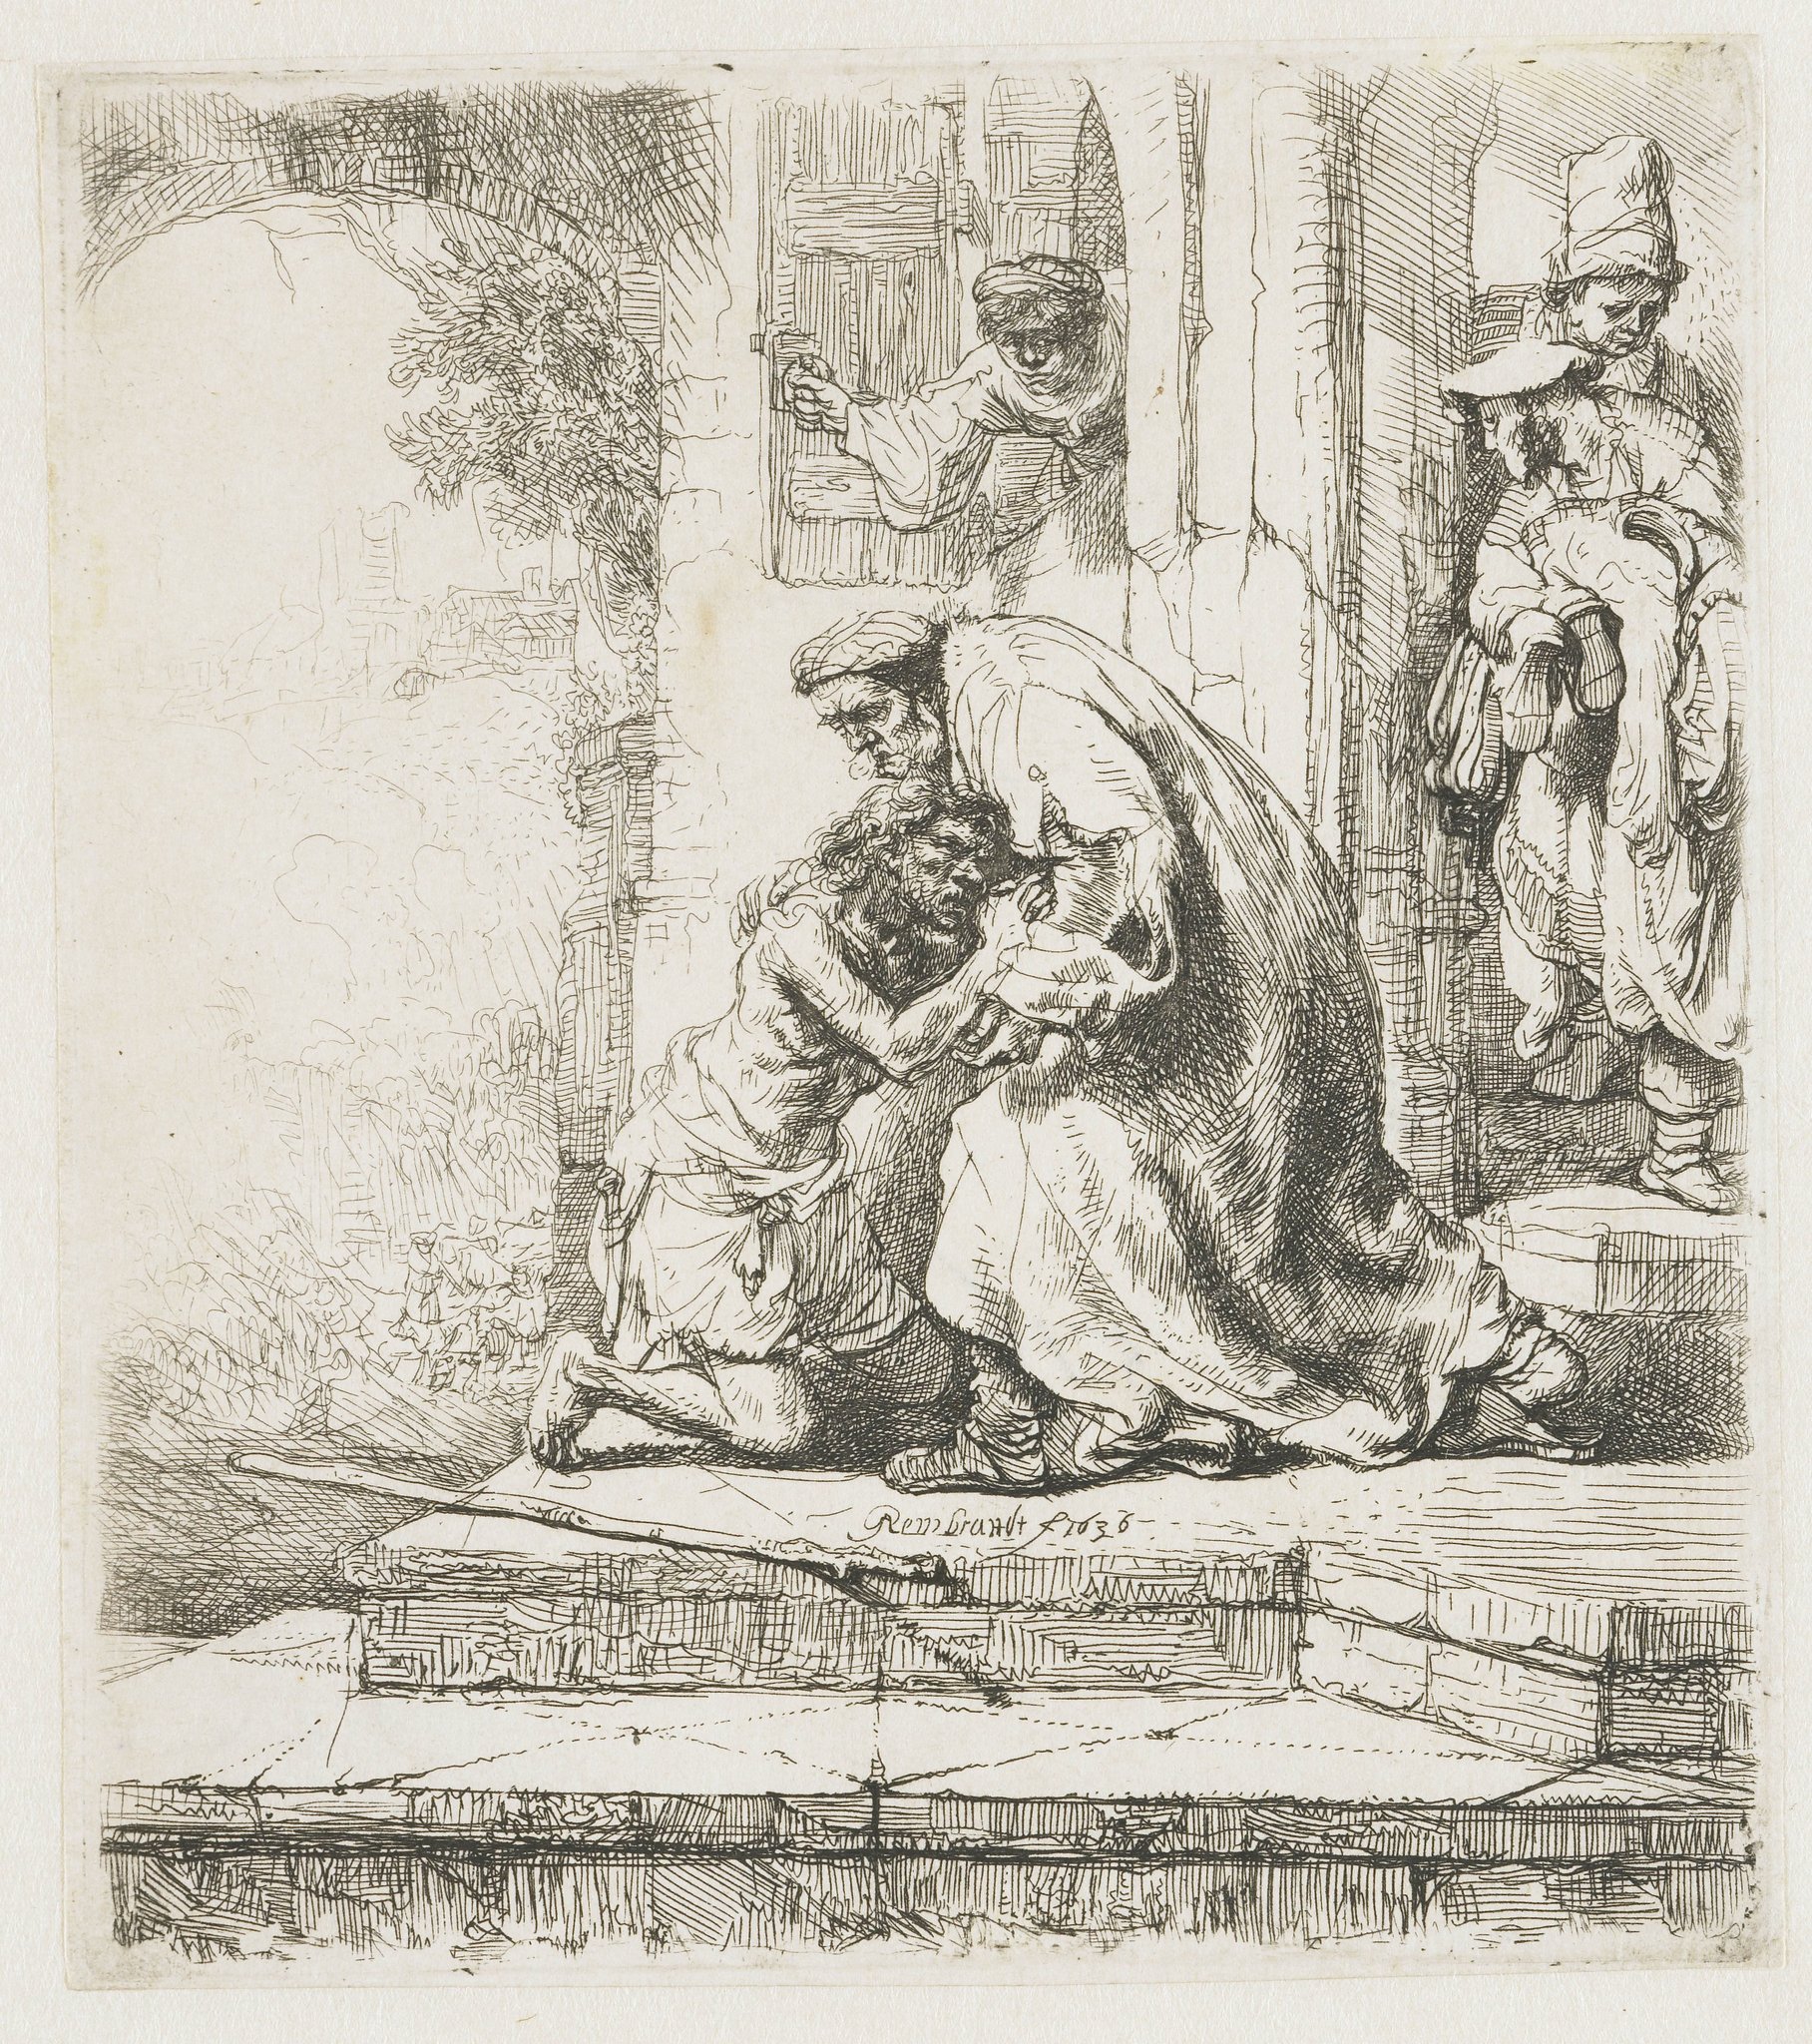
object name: print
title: The return of the prodigal son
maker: rembrandt van rijn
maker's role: draughtsman, painter, print maker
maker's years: 1606-1669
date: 1636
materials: paper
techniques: etching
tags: the parable of the prodigal son (luke 15:11-32)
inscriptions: mark: 2228, inscription: ‘6 fl’, signature and date: ‘Rembrandt f 1636’ Lugt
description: De terugkeer van de verloren zoon: hij knielt voor zijn vader op het bordes van zijn ouderlijk huis. In de deuropening twee figuren, een derde kijkt uit het venster.